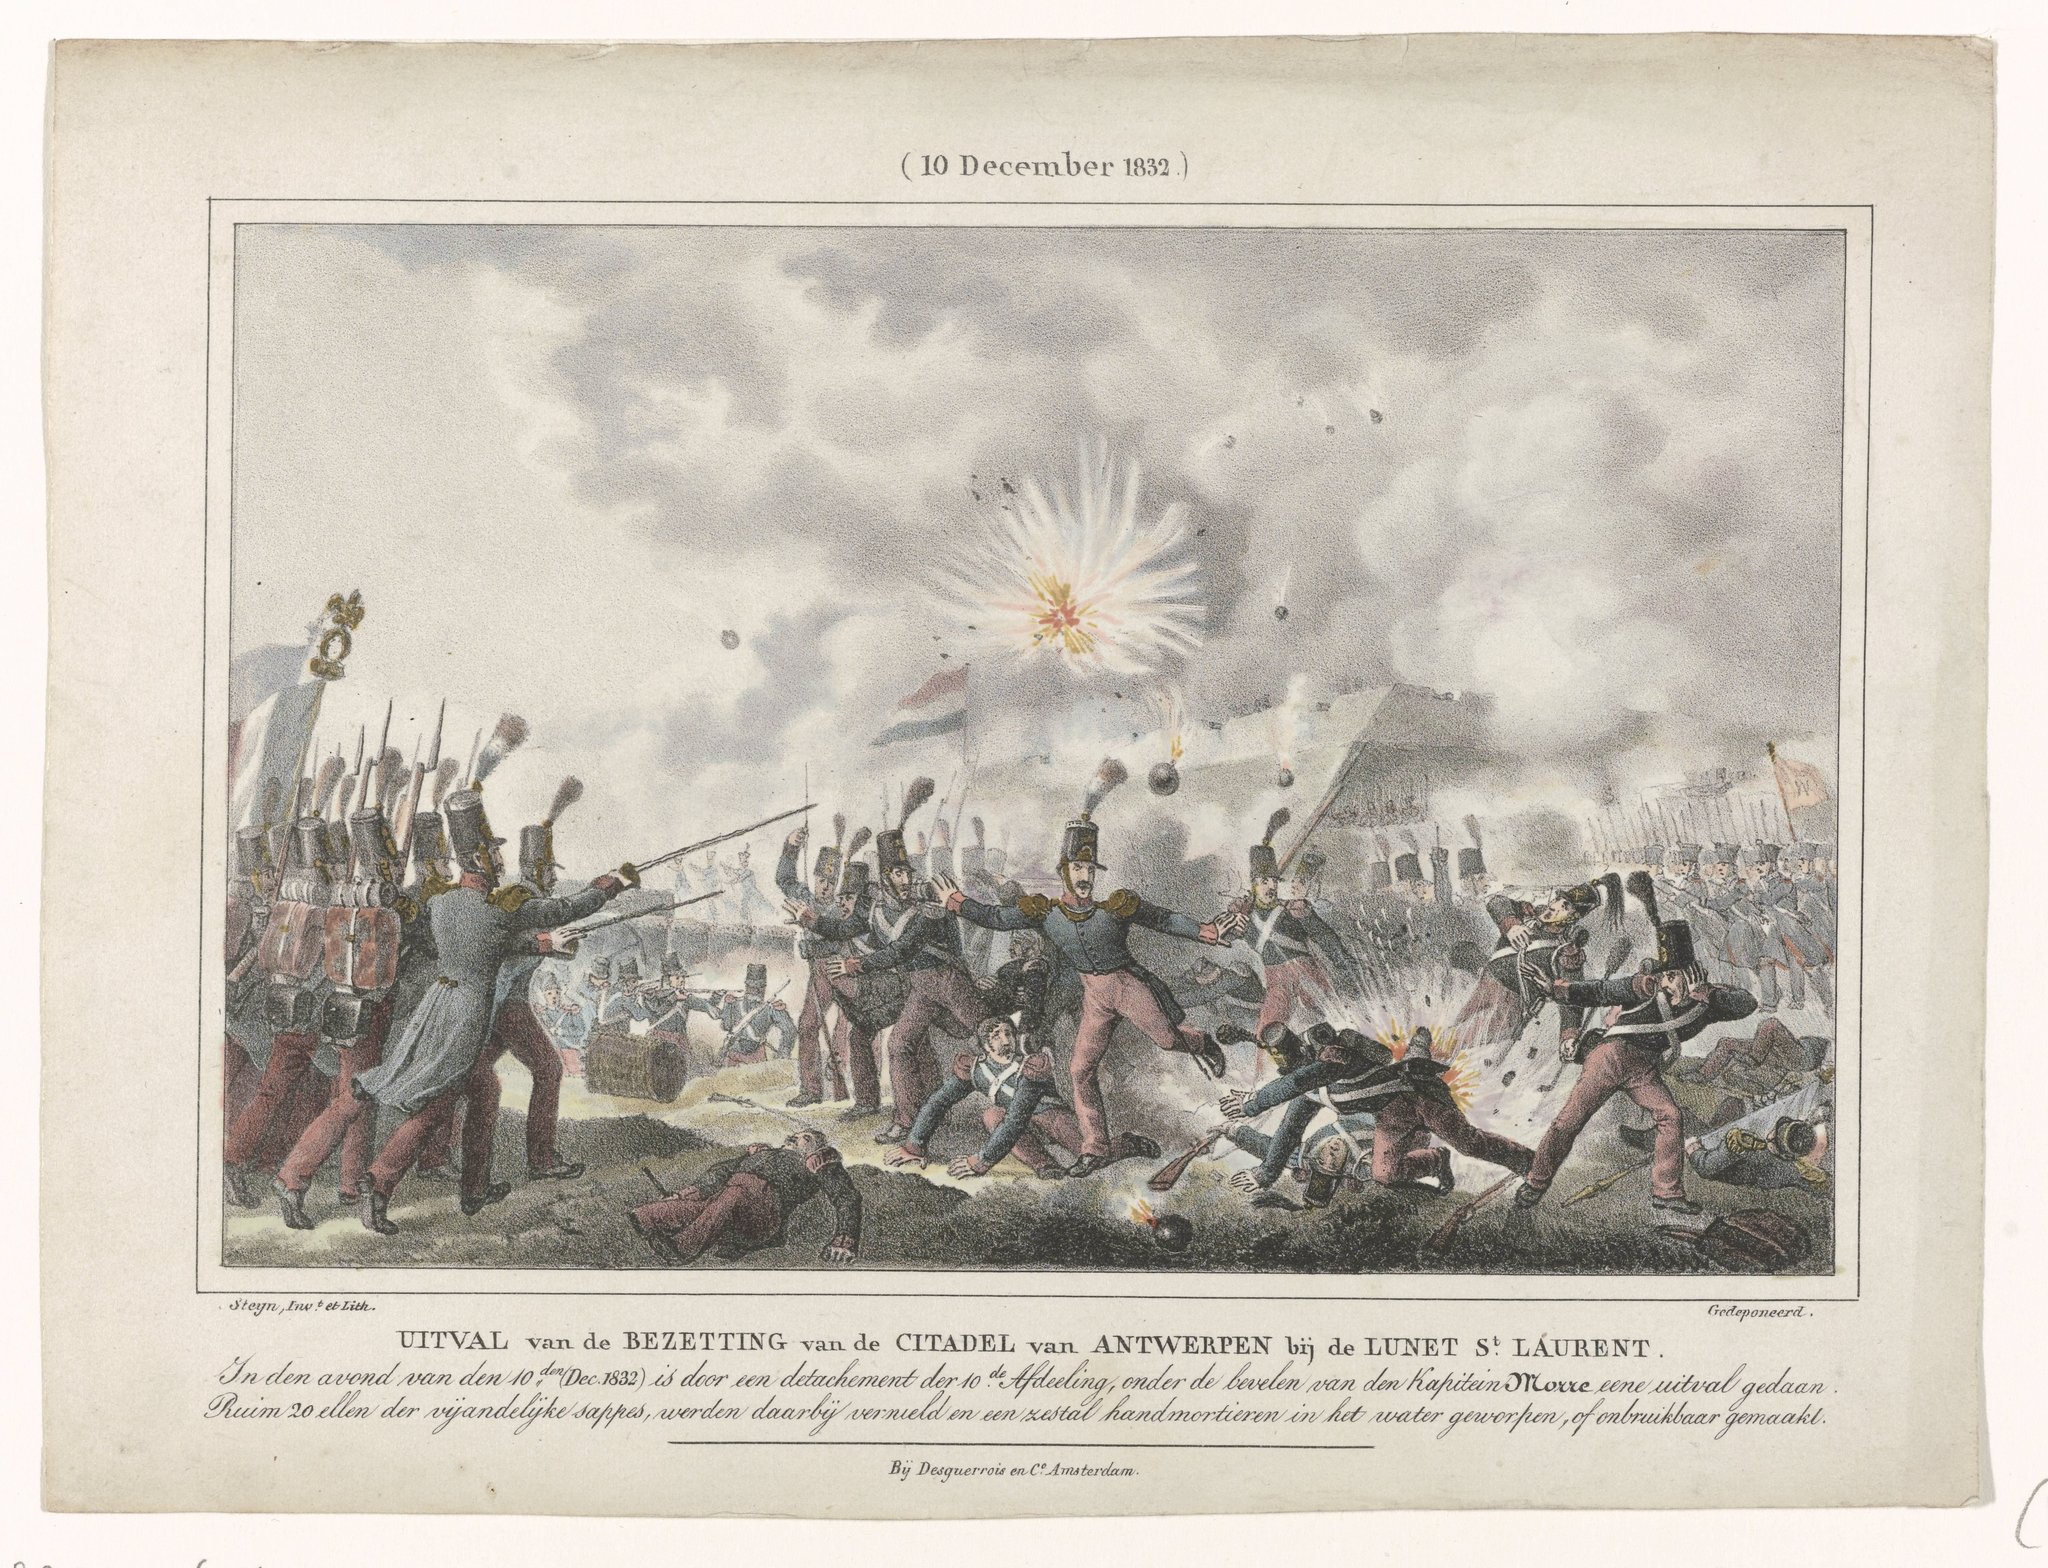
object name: print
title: Vier platen van de verdediging van de Citadel 10-18 december 1832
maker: johannes steyn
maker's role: print maker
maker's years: 1805-1840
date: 1832-1833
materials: paper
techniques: hand coloring, lithograph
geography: netherlands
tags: fortress, counter-attack from a fortification ~ siege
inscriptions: collector's mark: Lugt 2228, : ‘Gedeponeerd’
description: Uitval van een detachement van de 10e Afdeling van het Nederlandse leger onder bevel van kapitein Morre op 10 december 1832. Onderdeel van een serie van vier platen van de Nederlandse verdediging tijdens het beleg van de Citadel van Antwerpen door het Franse leger, december 1832.